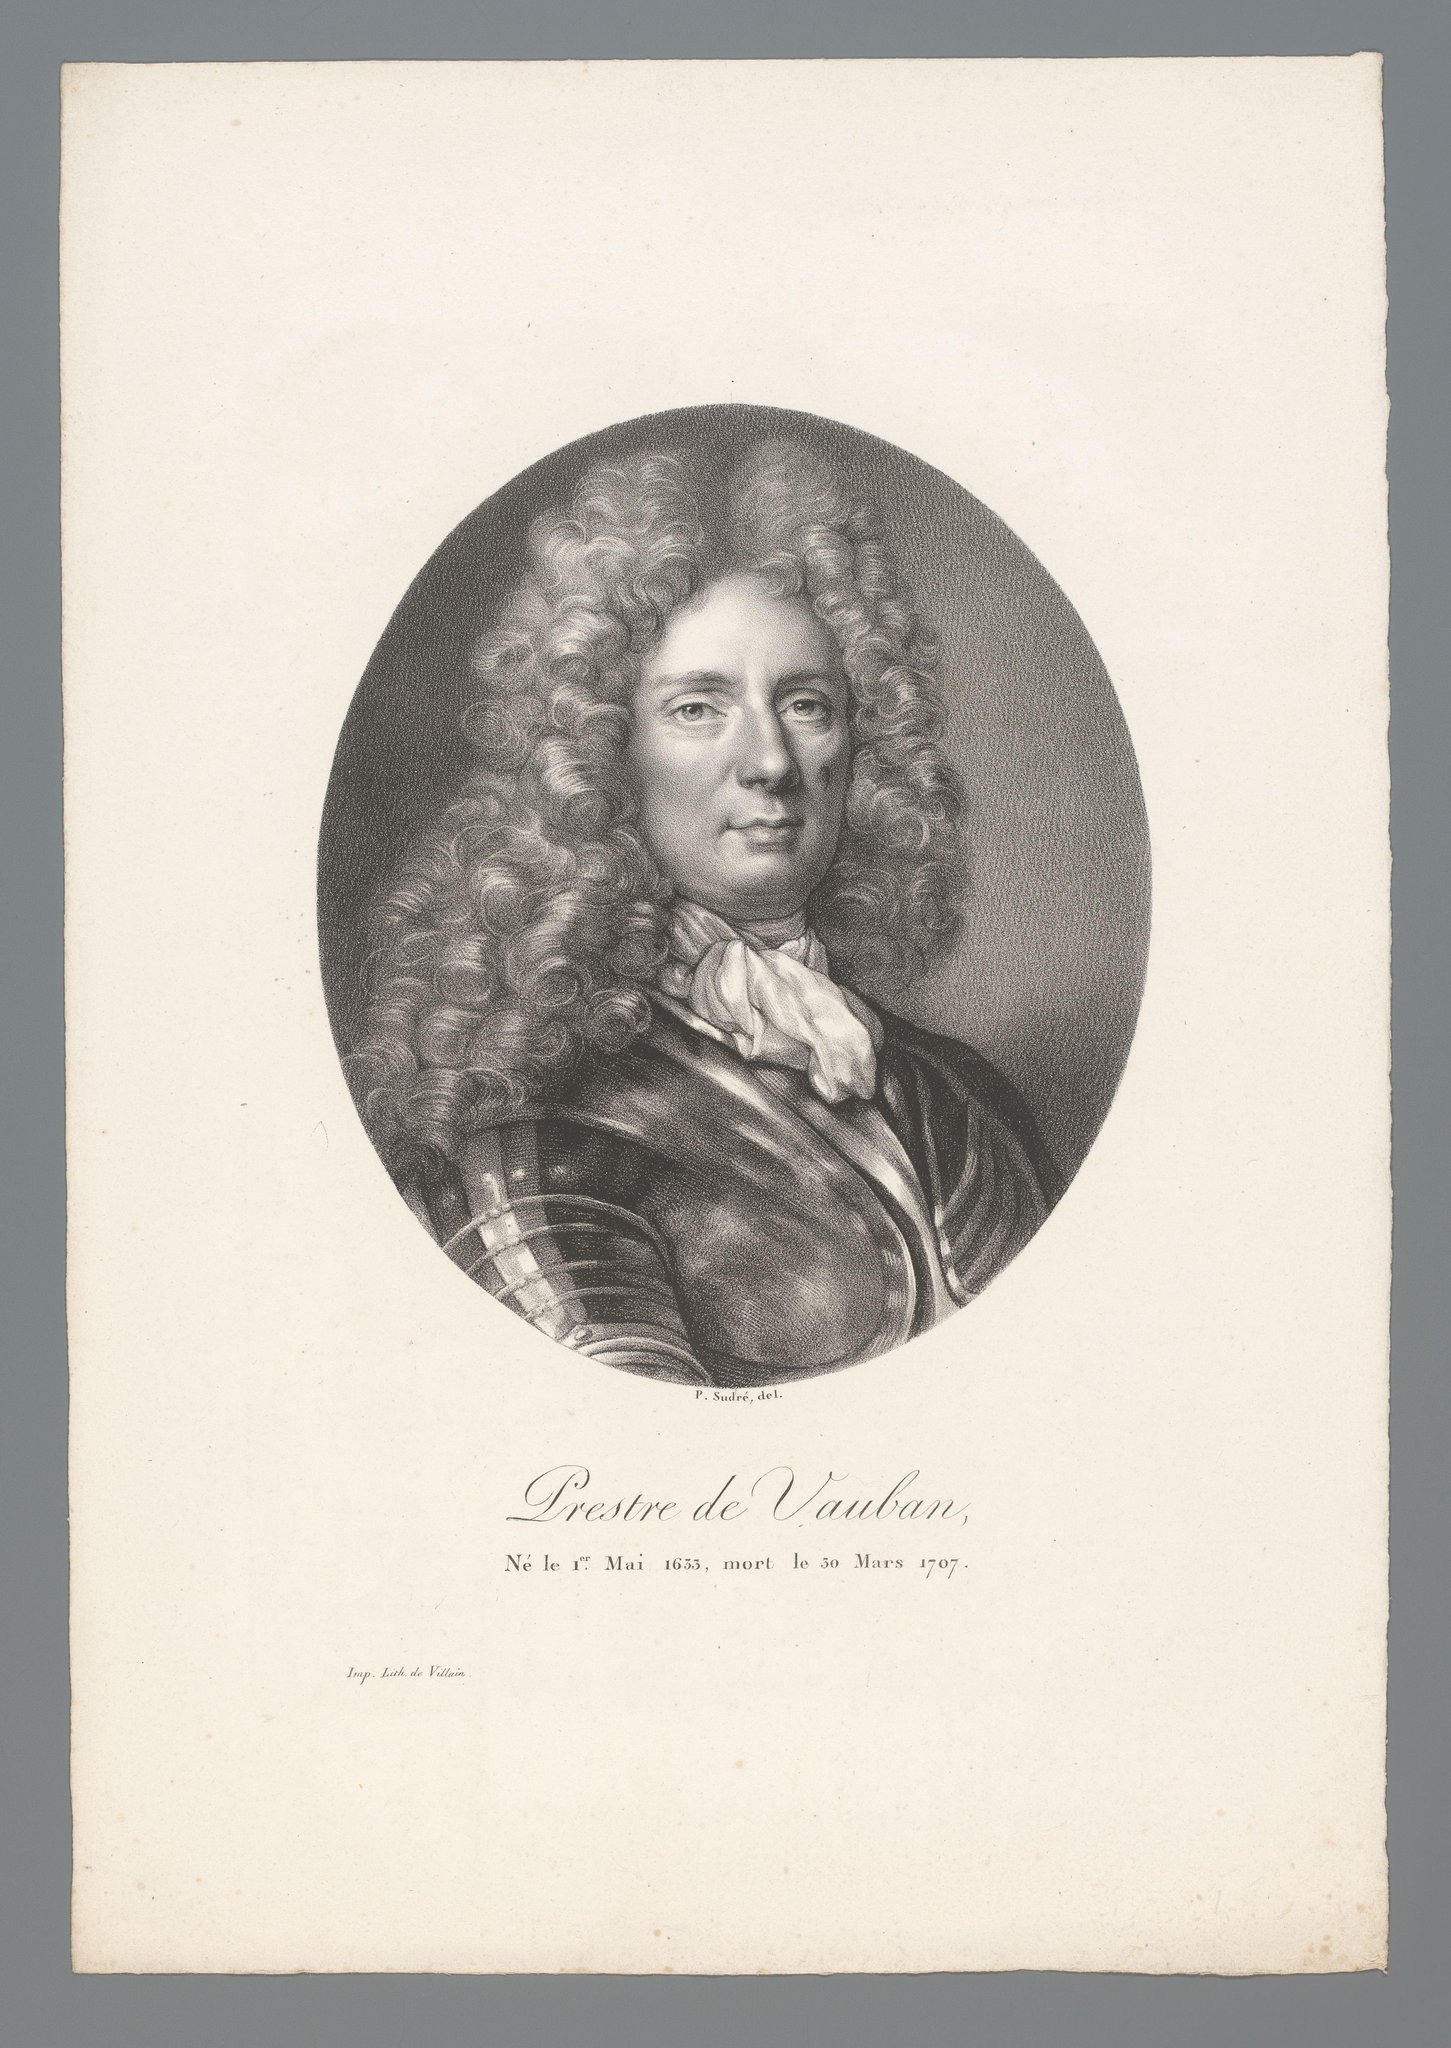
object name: print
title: Portret van architect Sébastien Le Prestre de Vauban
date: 1820-1827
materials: paper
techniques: lithograph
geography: paris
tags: engineer, sébastien le prestre de vauban, historical persons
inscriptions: collector's mark: Lugt 2228